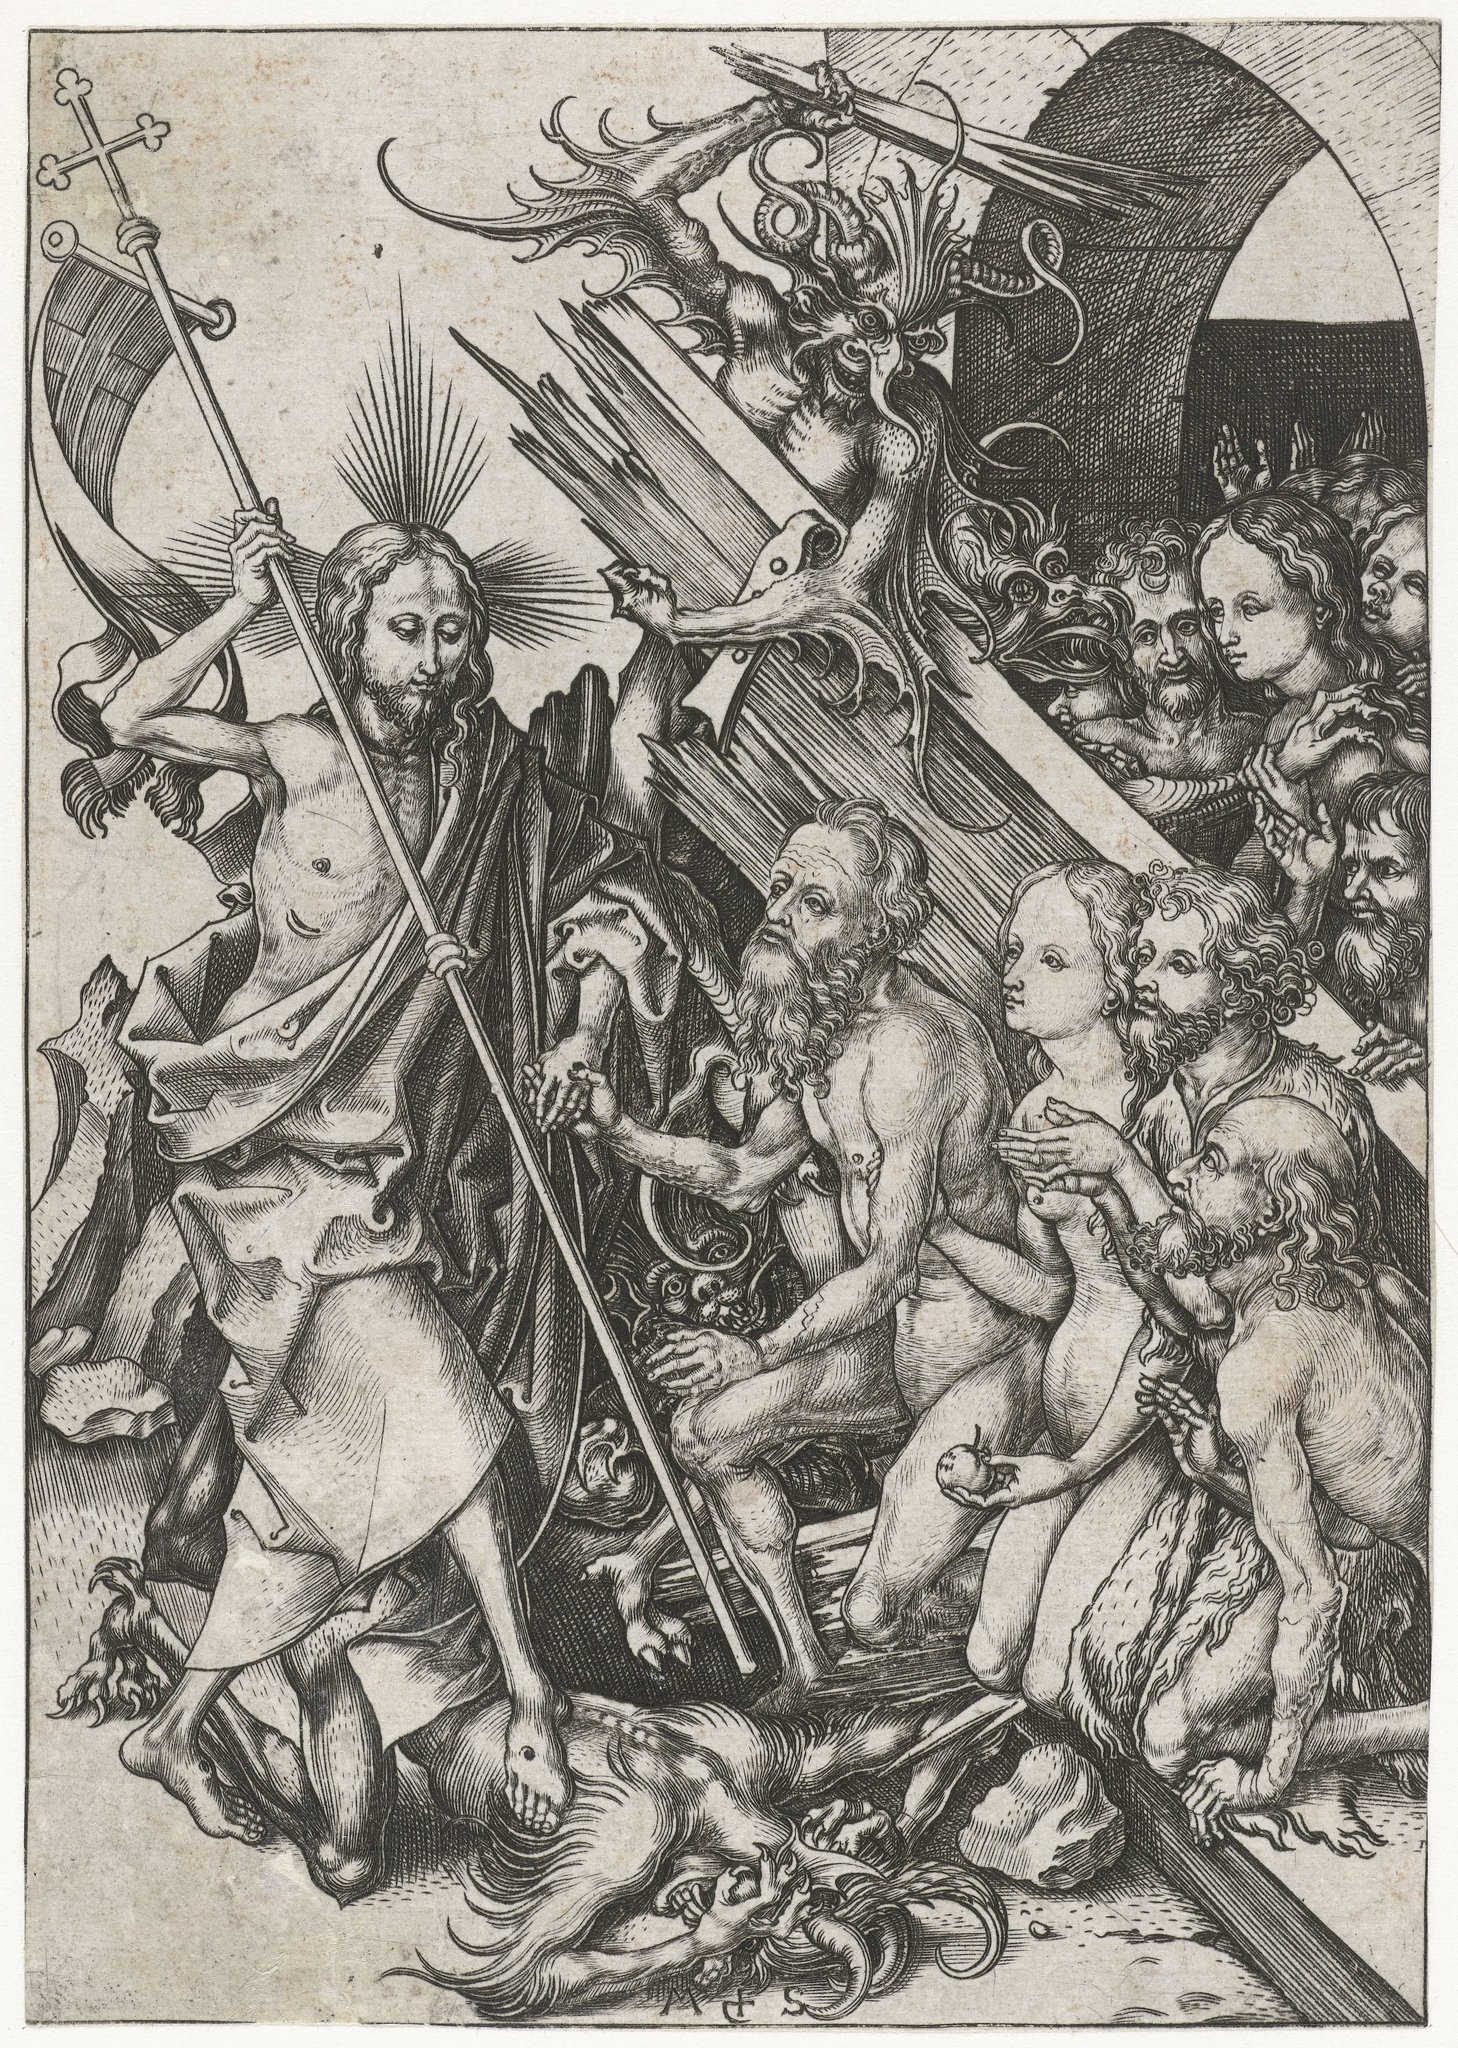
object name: print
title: De Passie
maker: martin schongauer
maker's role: print maker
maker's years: 1430-1491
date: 1470-1491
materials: paper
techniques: engraving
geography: germany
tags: christ leaving hell: he liberates patriarchs, prophets, kings and other persons from hell, among them adam, eve, moses, david, and john the baptist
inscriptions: collector's mark: Lugt 240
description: Christus, een staf met een vaan in de hand, bevrijdt een groep zielen uit een kerker. Duivels proberen de zielen nog terug te dringen, maar worden vertrapt of tegengehouden door Christus. Deze prent is onderdeel van een serie van twaalf prenten met scènes uit het Lijdensverhaal.